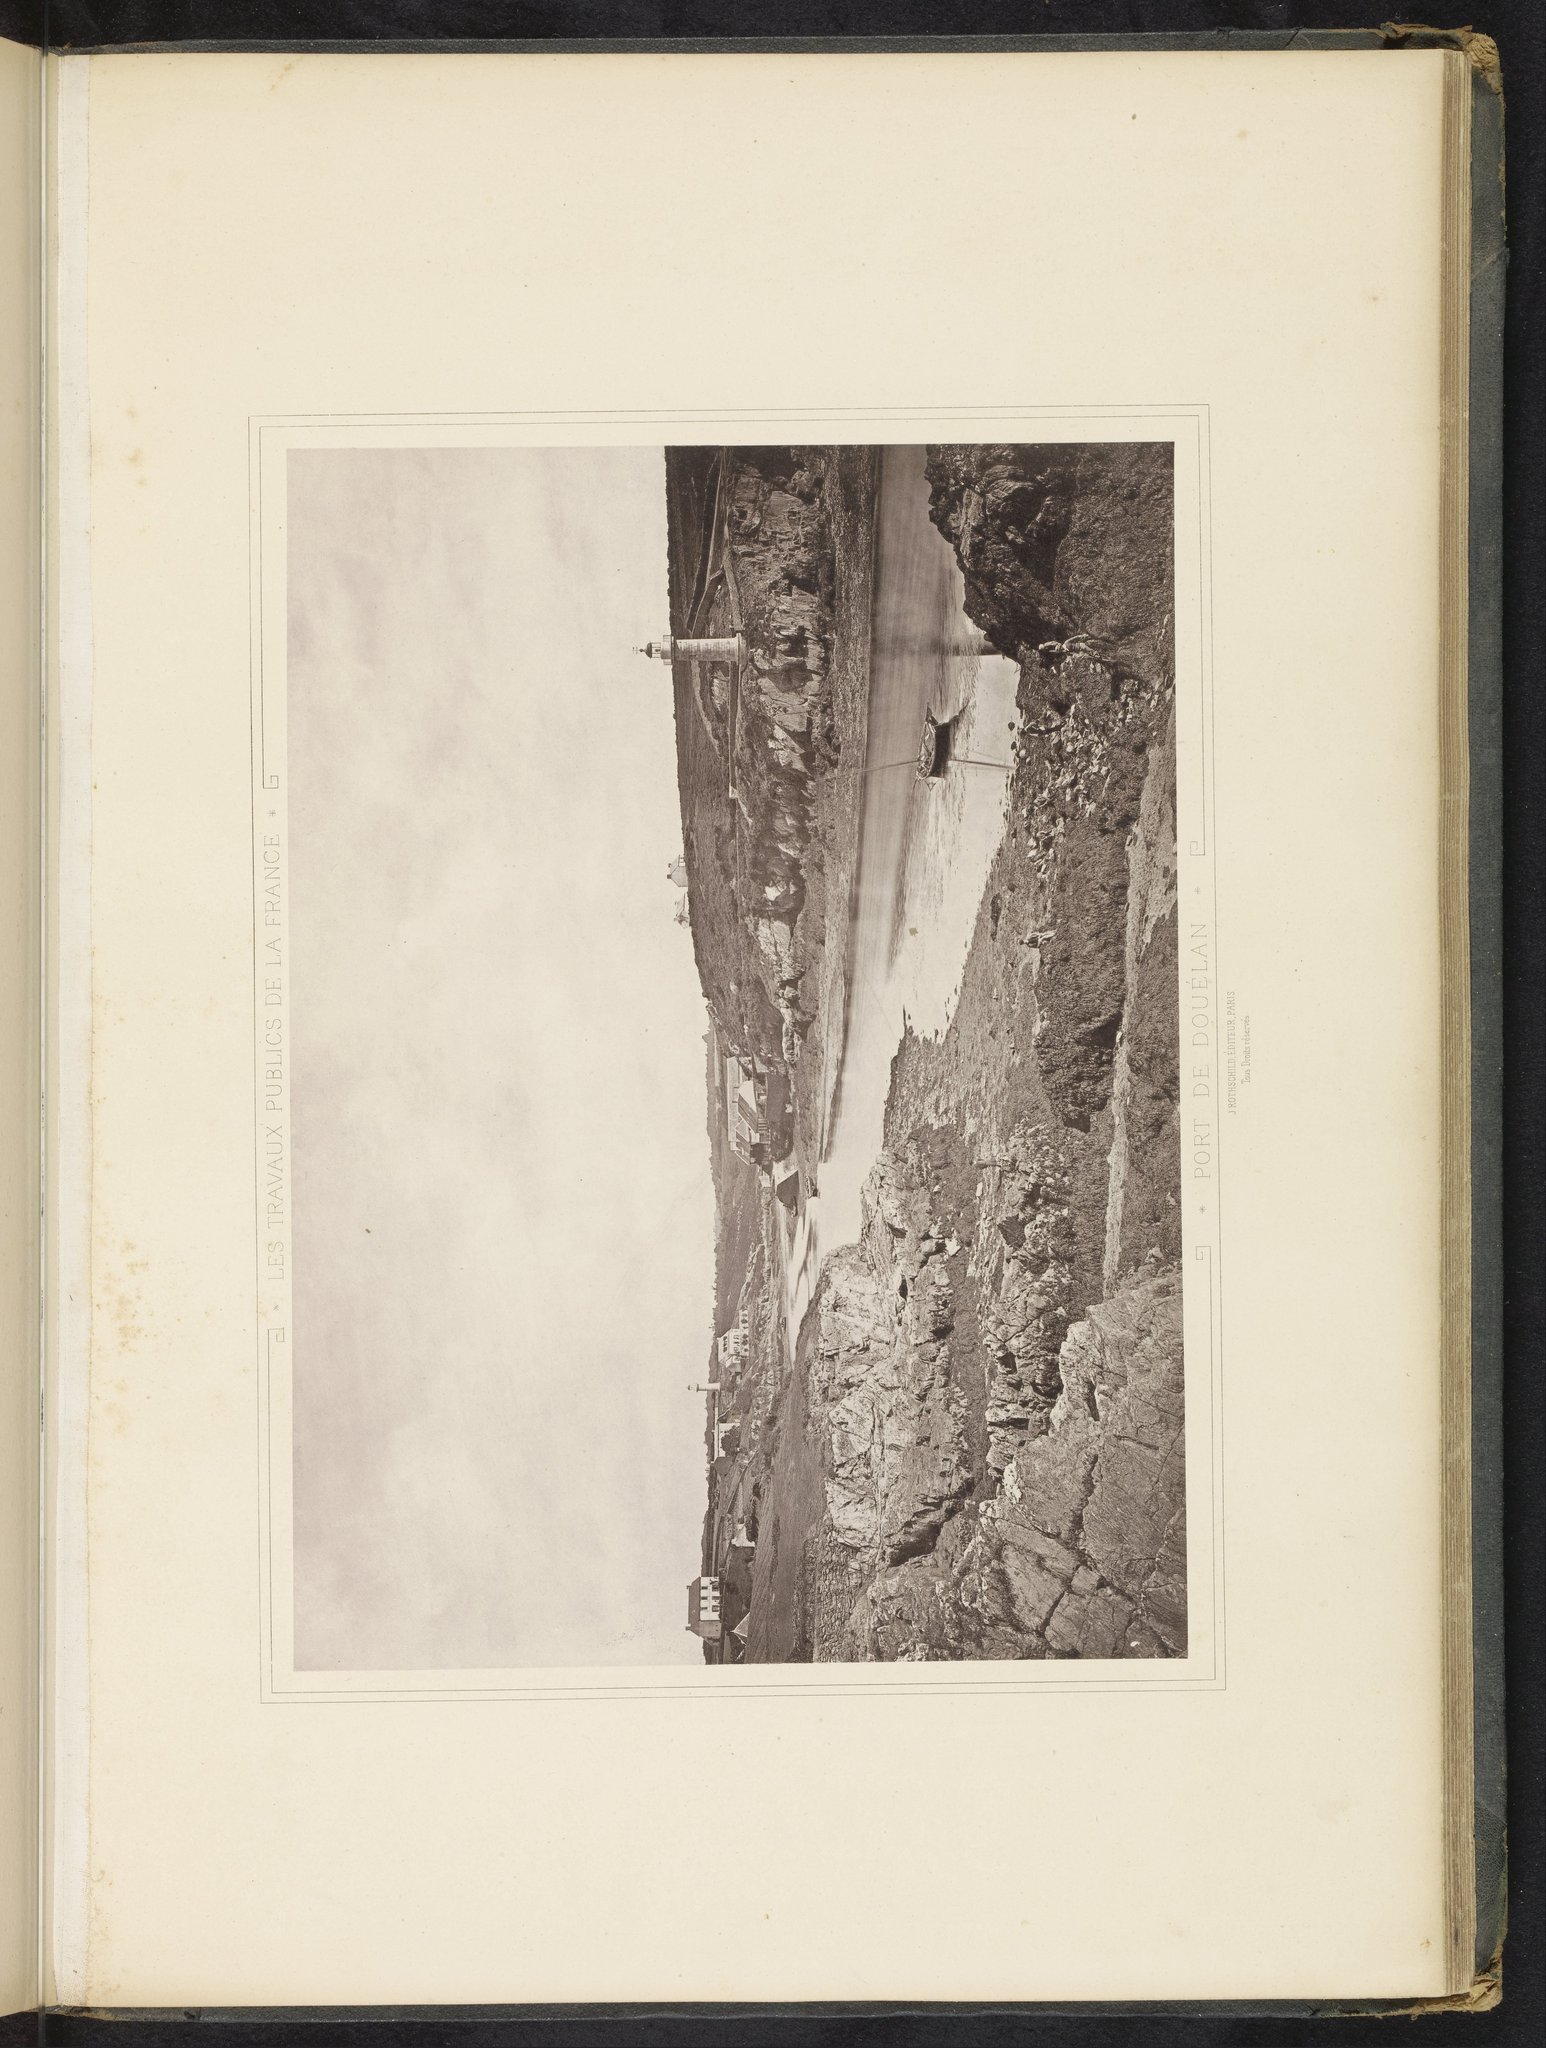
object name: photomechanical print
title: Gezicht op de haven van Doëlan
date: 1873-1883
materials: paper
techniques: photograph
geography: paris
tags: harbour, lighthouse, lightship